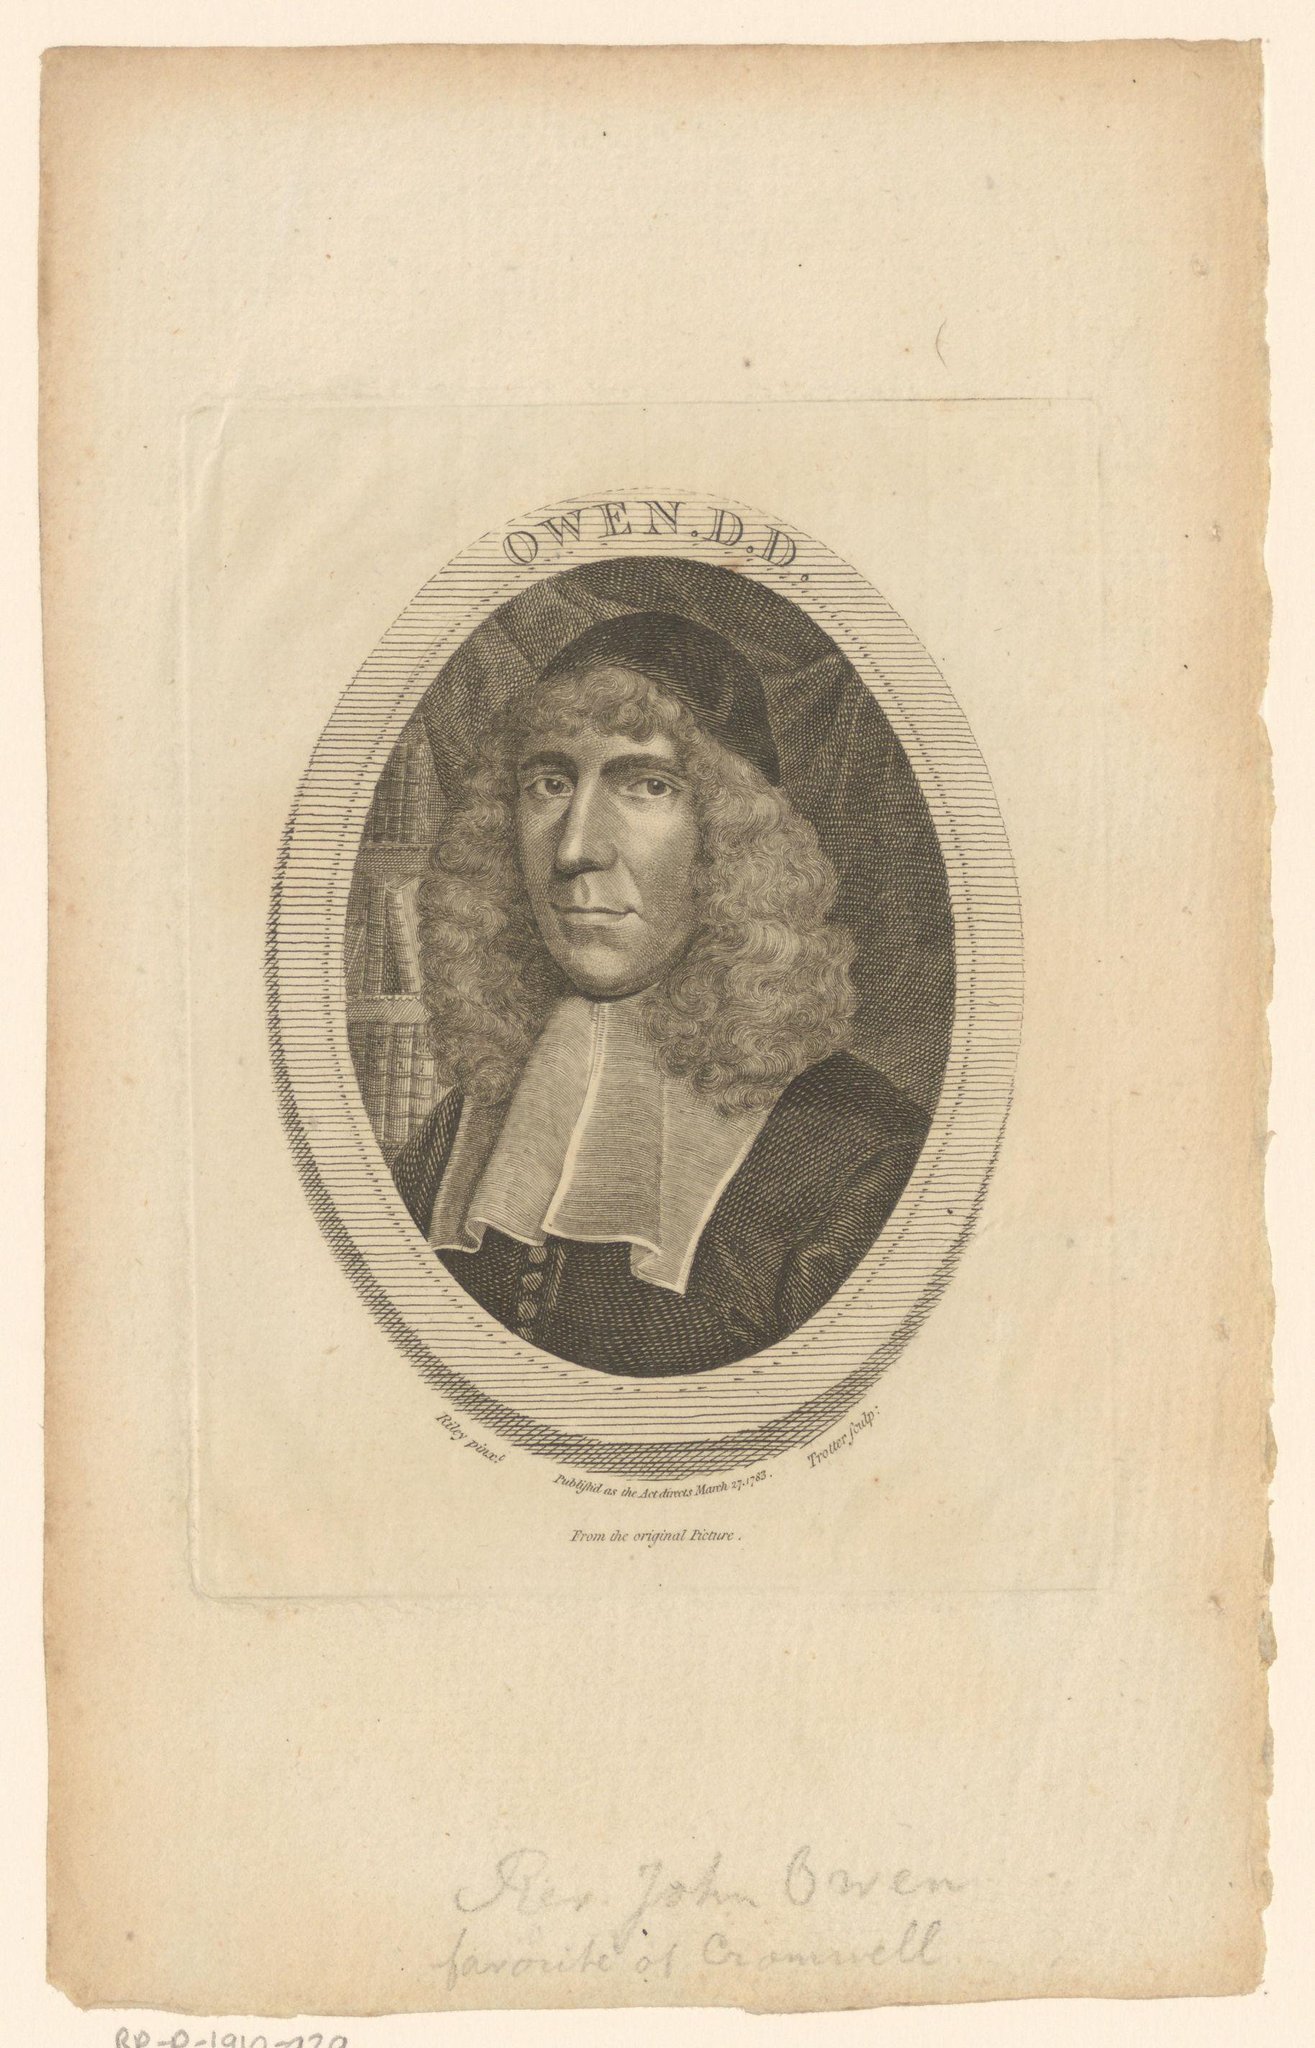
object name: book illustration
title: Portret van John Owen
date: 1703-1783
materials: paper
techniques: engraving, etching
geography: london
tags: theologian, historical persons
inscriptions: collector's mark: Lugt 2228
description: Prent uit: Middleton, Erasmus. Biographia Evangelica (...). Londen: Alexander Hogg, 1783.